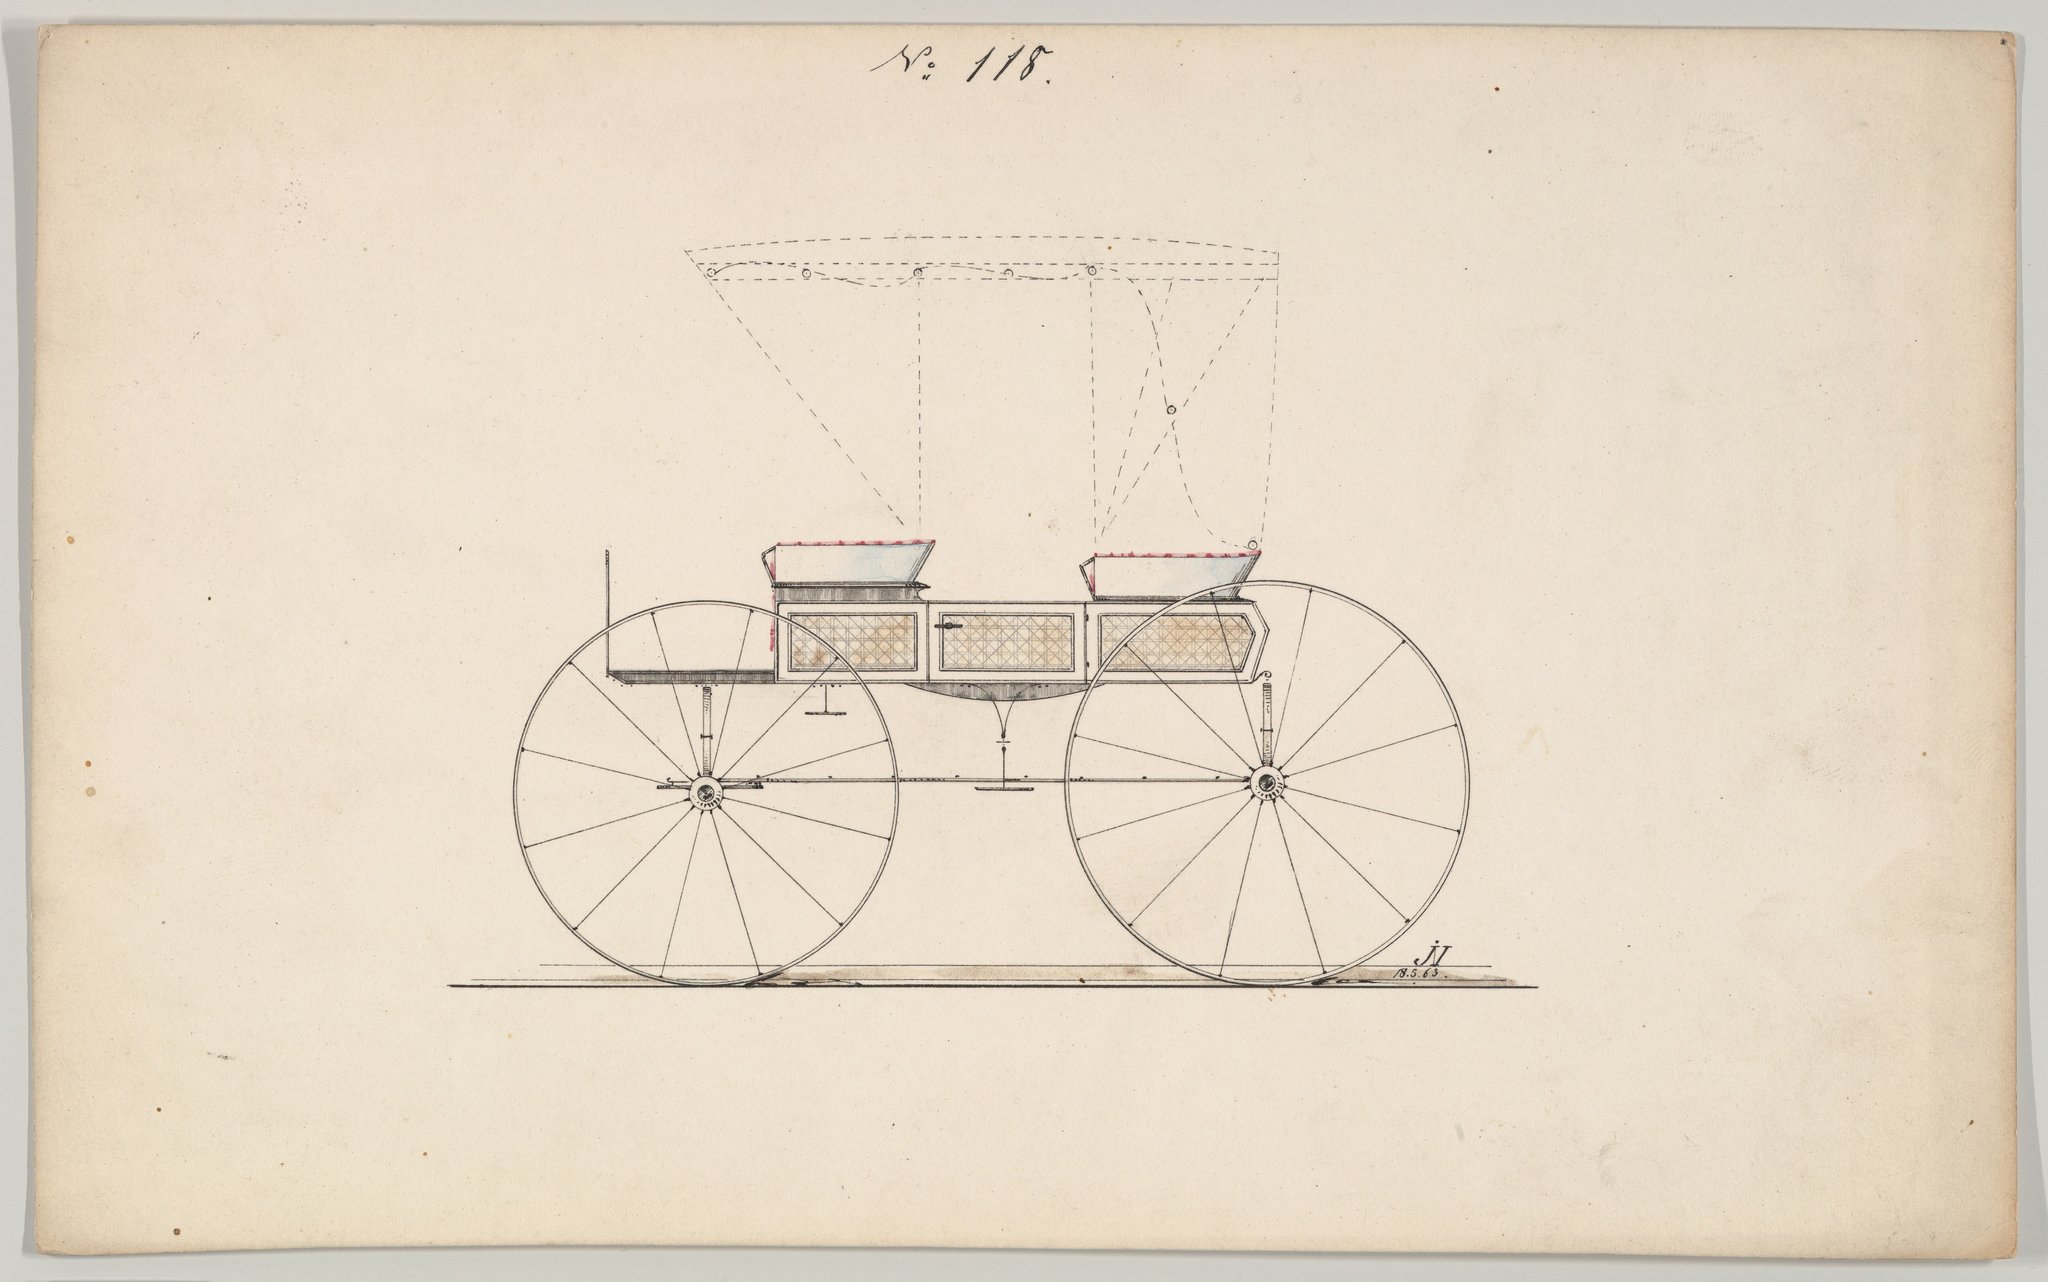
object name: drawing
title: Extension Top Phaeton #118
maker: brewster & co.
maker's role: manufacturer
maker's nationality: american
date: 1863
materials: ink, watercolor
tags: carriages